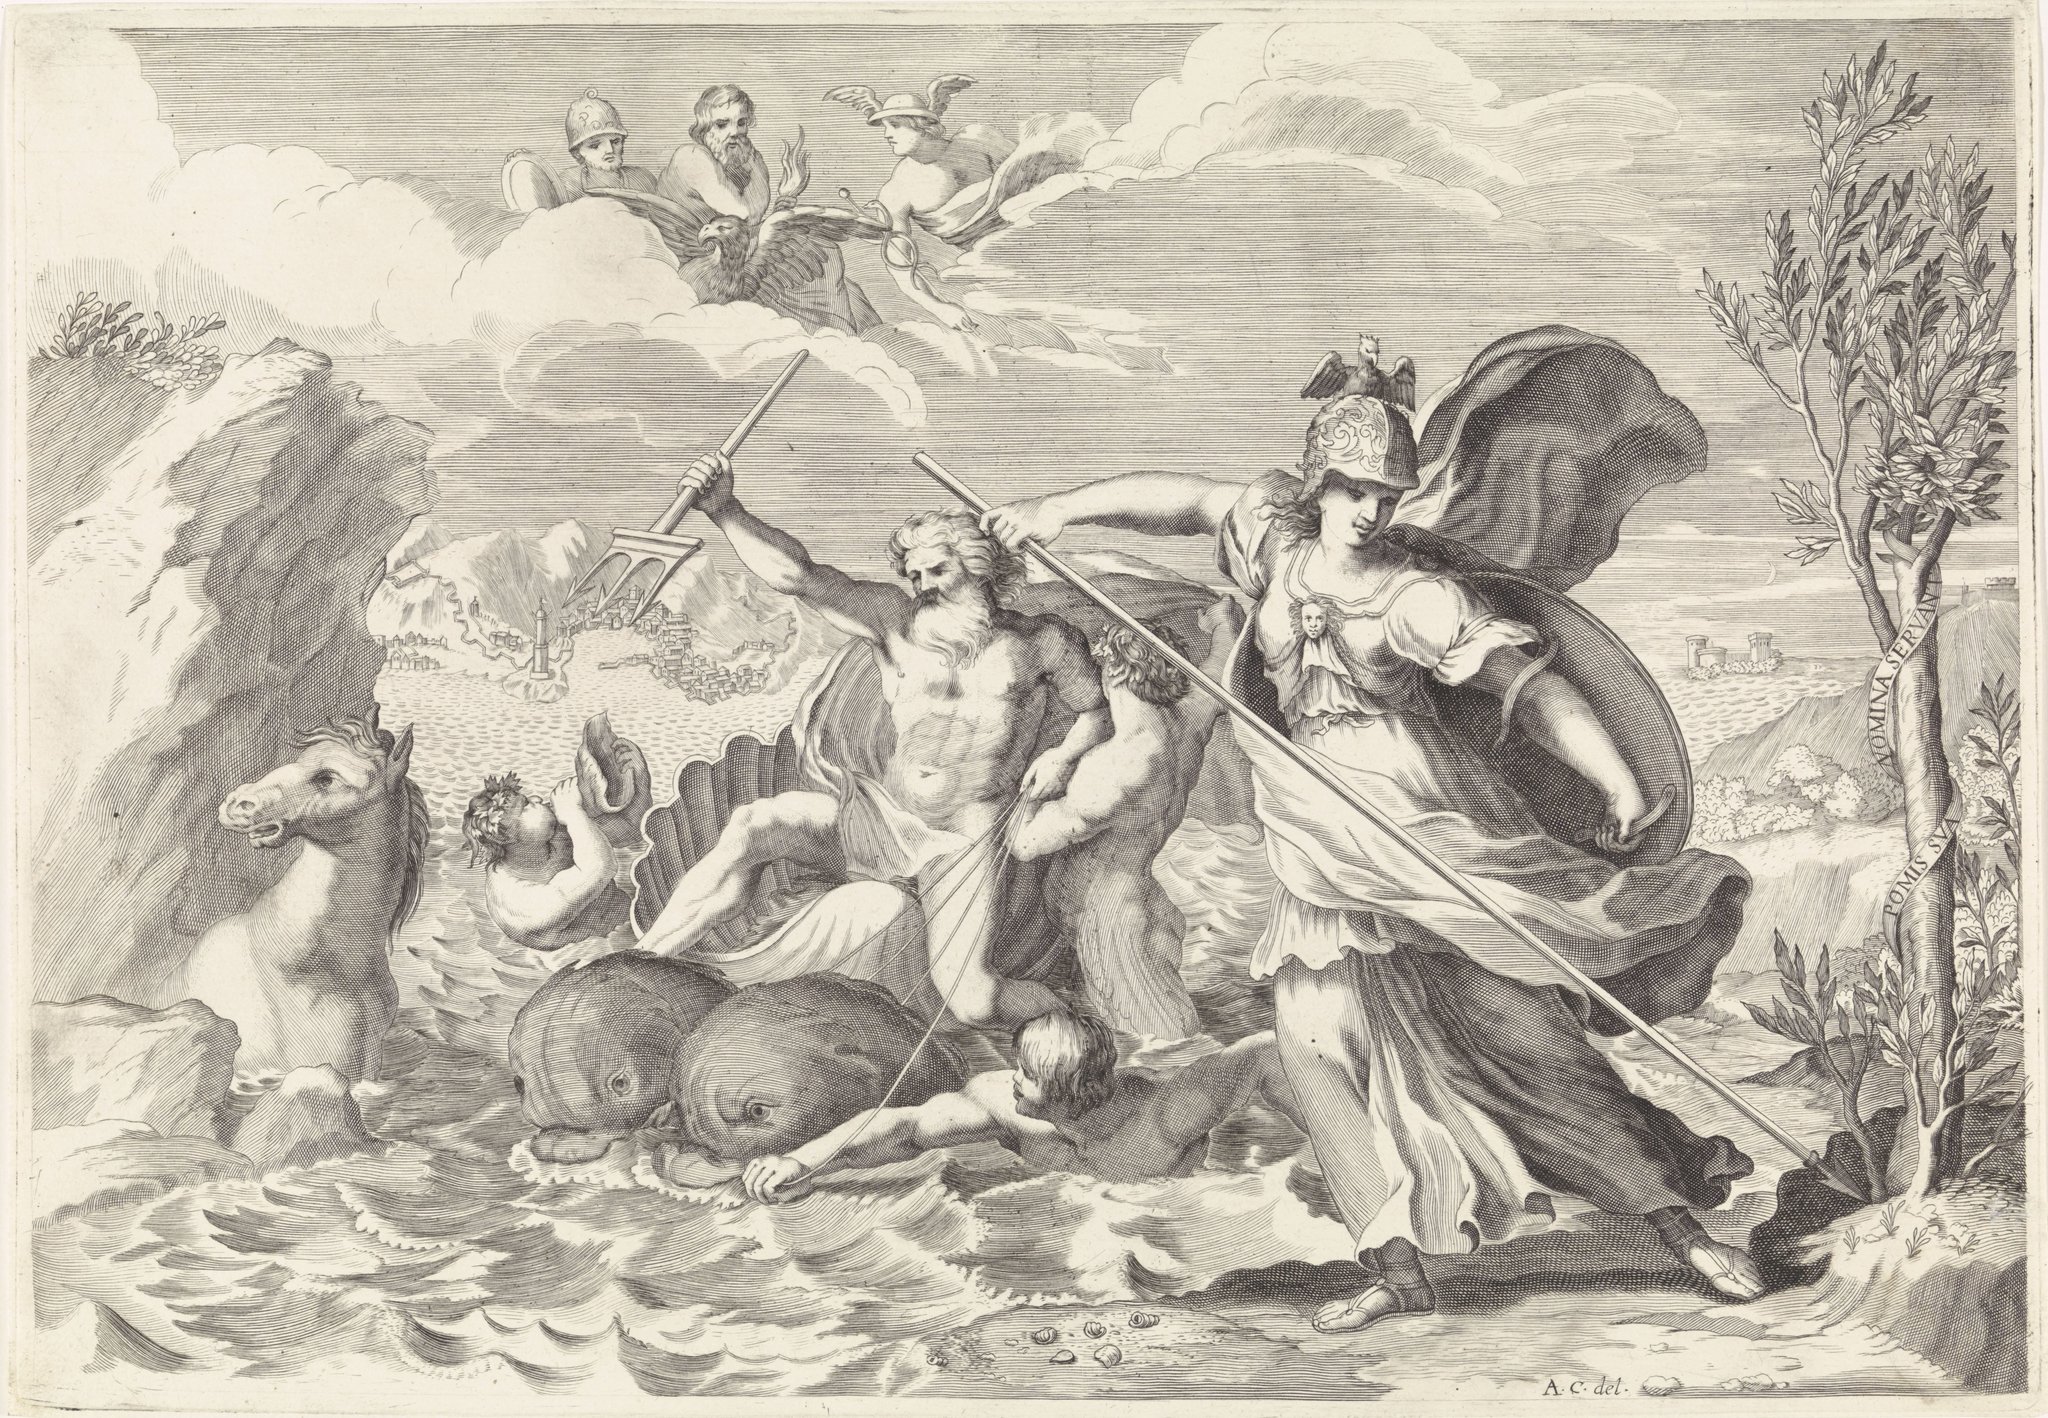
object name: print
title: Krachtmeting tussen Minerva en Neptunus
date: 1632-1633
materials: paper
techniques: engraving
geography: rome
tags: minerva in contest with neptune for athens: minerva creates the olive-tree, neptune the horse; jupiter and other olympians look on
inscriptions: collector's mark: Lugt 240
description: Minerva en Neptunus betwisten elkaar het bezit van Attica, de streek waar Athene de hoofdstad van was. De goden beloofden het land aan degene, die de inwoners het nuttigste geschenk konden bezorgen. Neptunus creëert met zijn drietand het paard. Tritons begeleiden Neptunus. Rechts staat Minerva op het land, met speer en schild, waar zij een olijfboom laat opschieten. Op een banderol om de boom de tekst: Pomis sva nomina servant. Op de wolken kijken de goden Jupiter, Mars en Mercurius toe. Links op de achtergrond ligt de stad Athene.